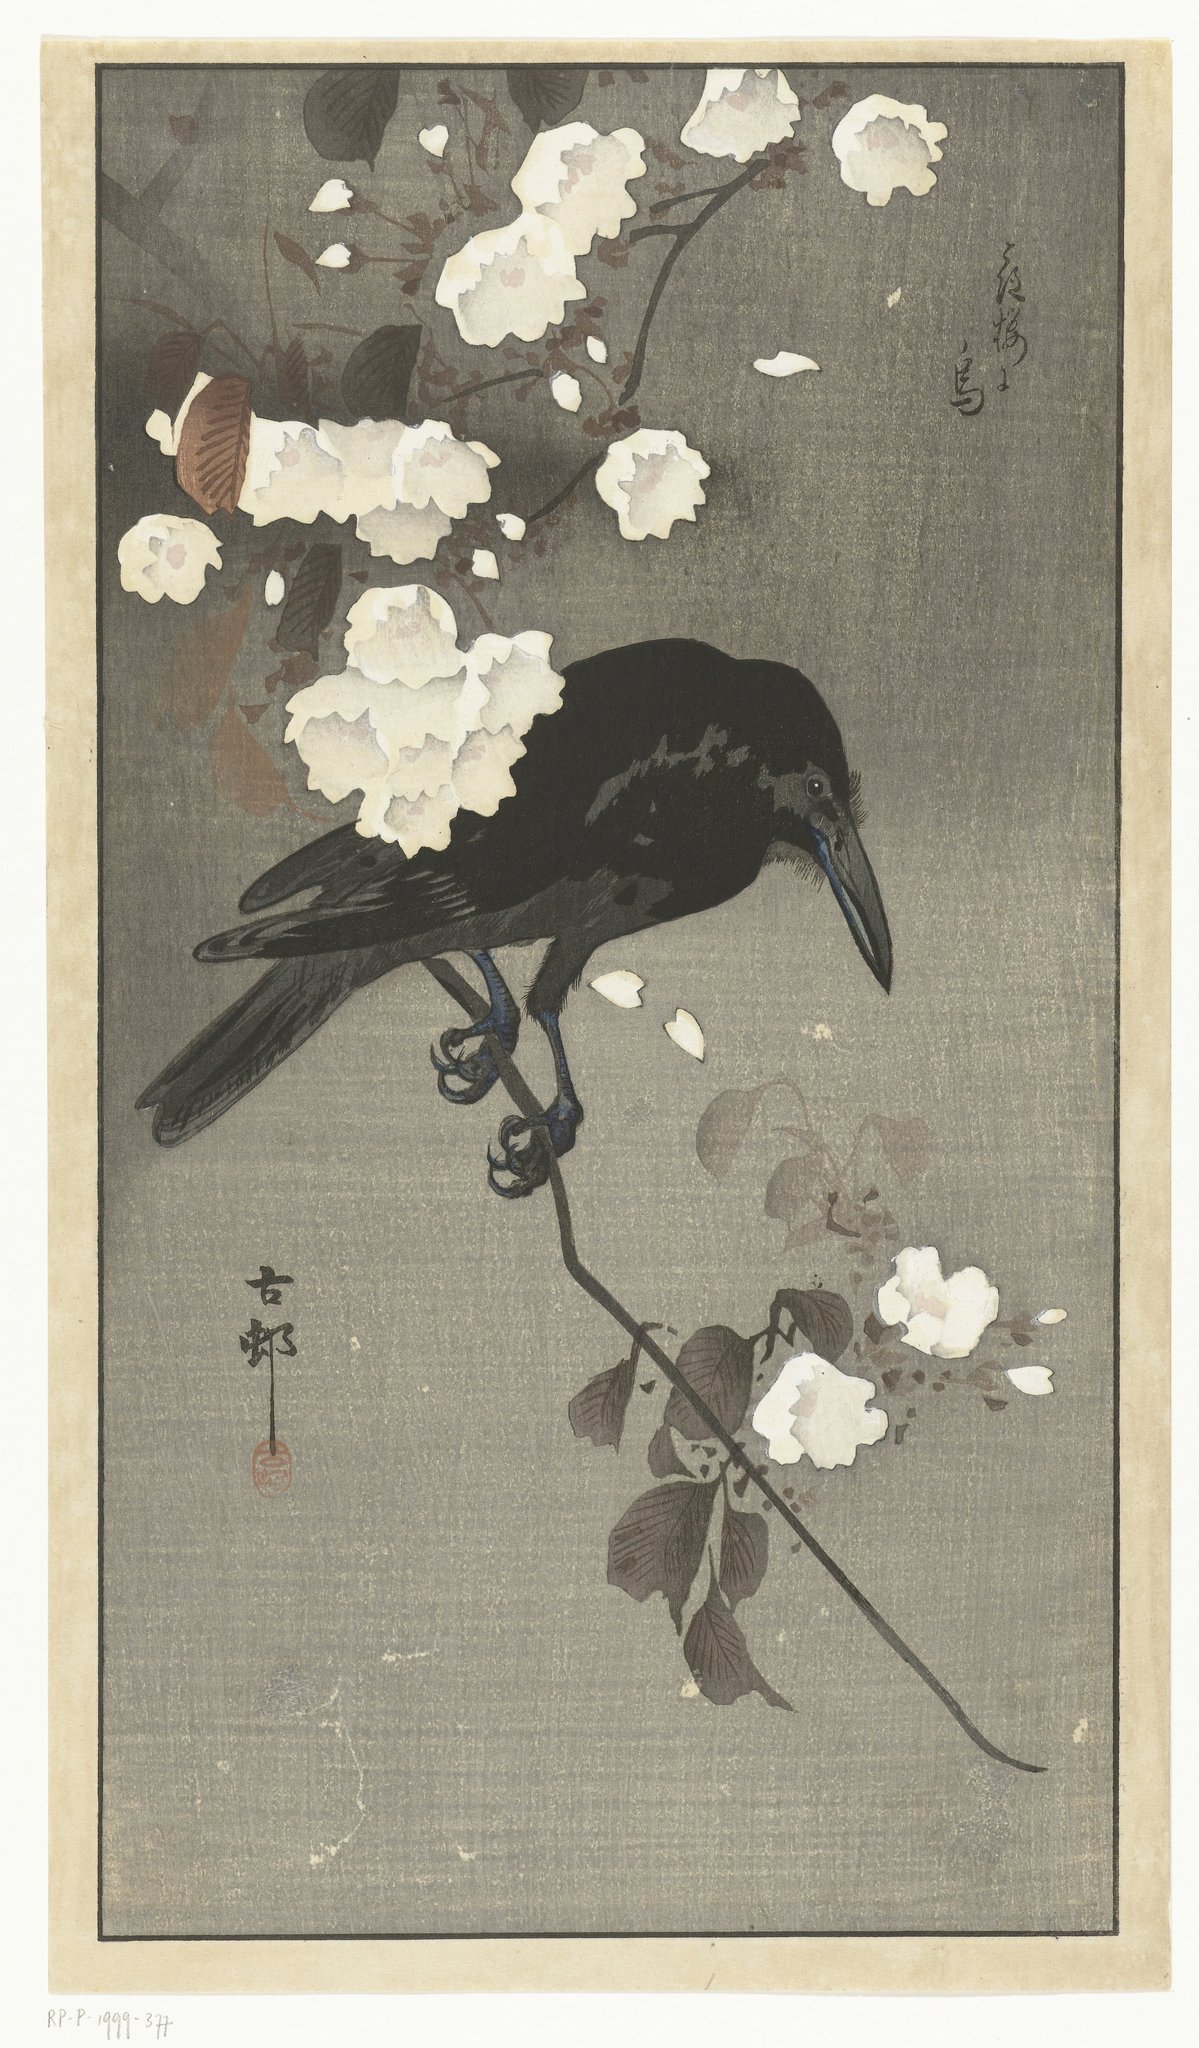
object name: print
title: Hana sakura no tori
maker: ohara koson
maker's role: print maker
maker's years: 1877-1945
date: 1900-1930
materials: paper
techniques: woodcut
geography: japan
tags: song-birds: crow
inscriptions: collector's mark: Lugt 2228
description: Kraai, naar rechts, op tak met witte kersenbloesem.; tegen grijze achtergrond.